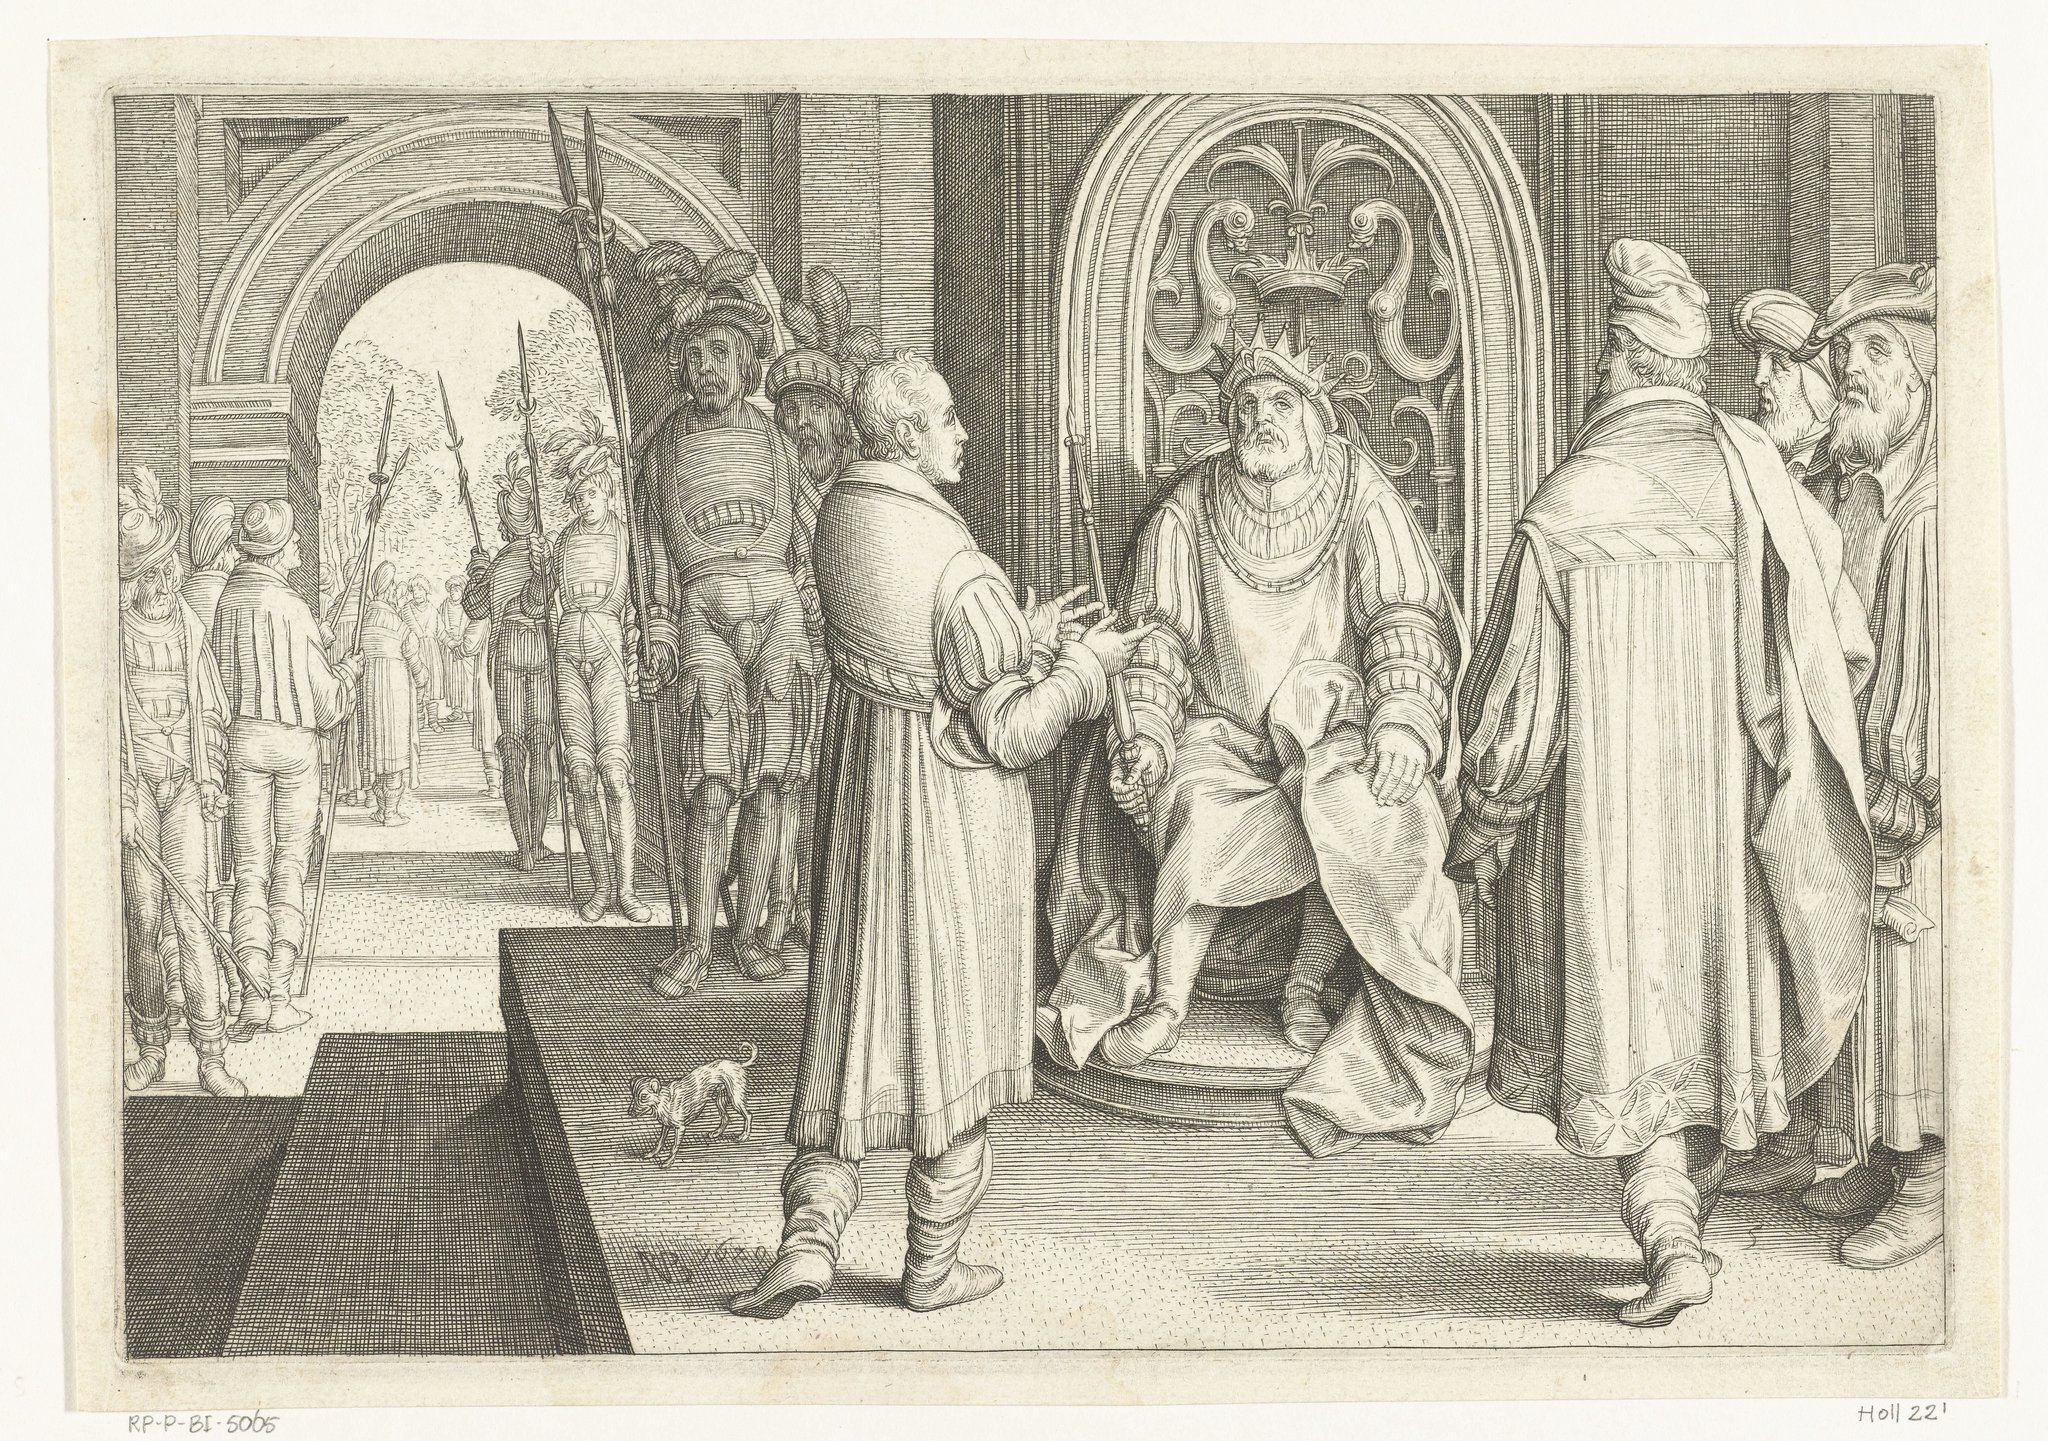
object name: print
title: Jozef legt dromen van de farao uit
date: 1629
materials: paper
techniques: engraving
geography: netherlands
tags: joseph interpreting pharaoh's dreams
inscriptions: collector's mark: Lugt 2228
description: Prent uit serie van zes prenten met het verhaal van Jozef. De serie is geïnspireerd op een vergelijkbare reeks van Lucas van Leyden.